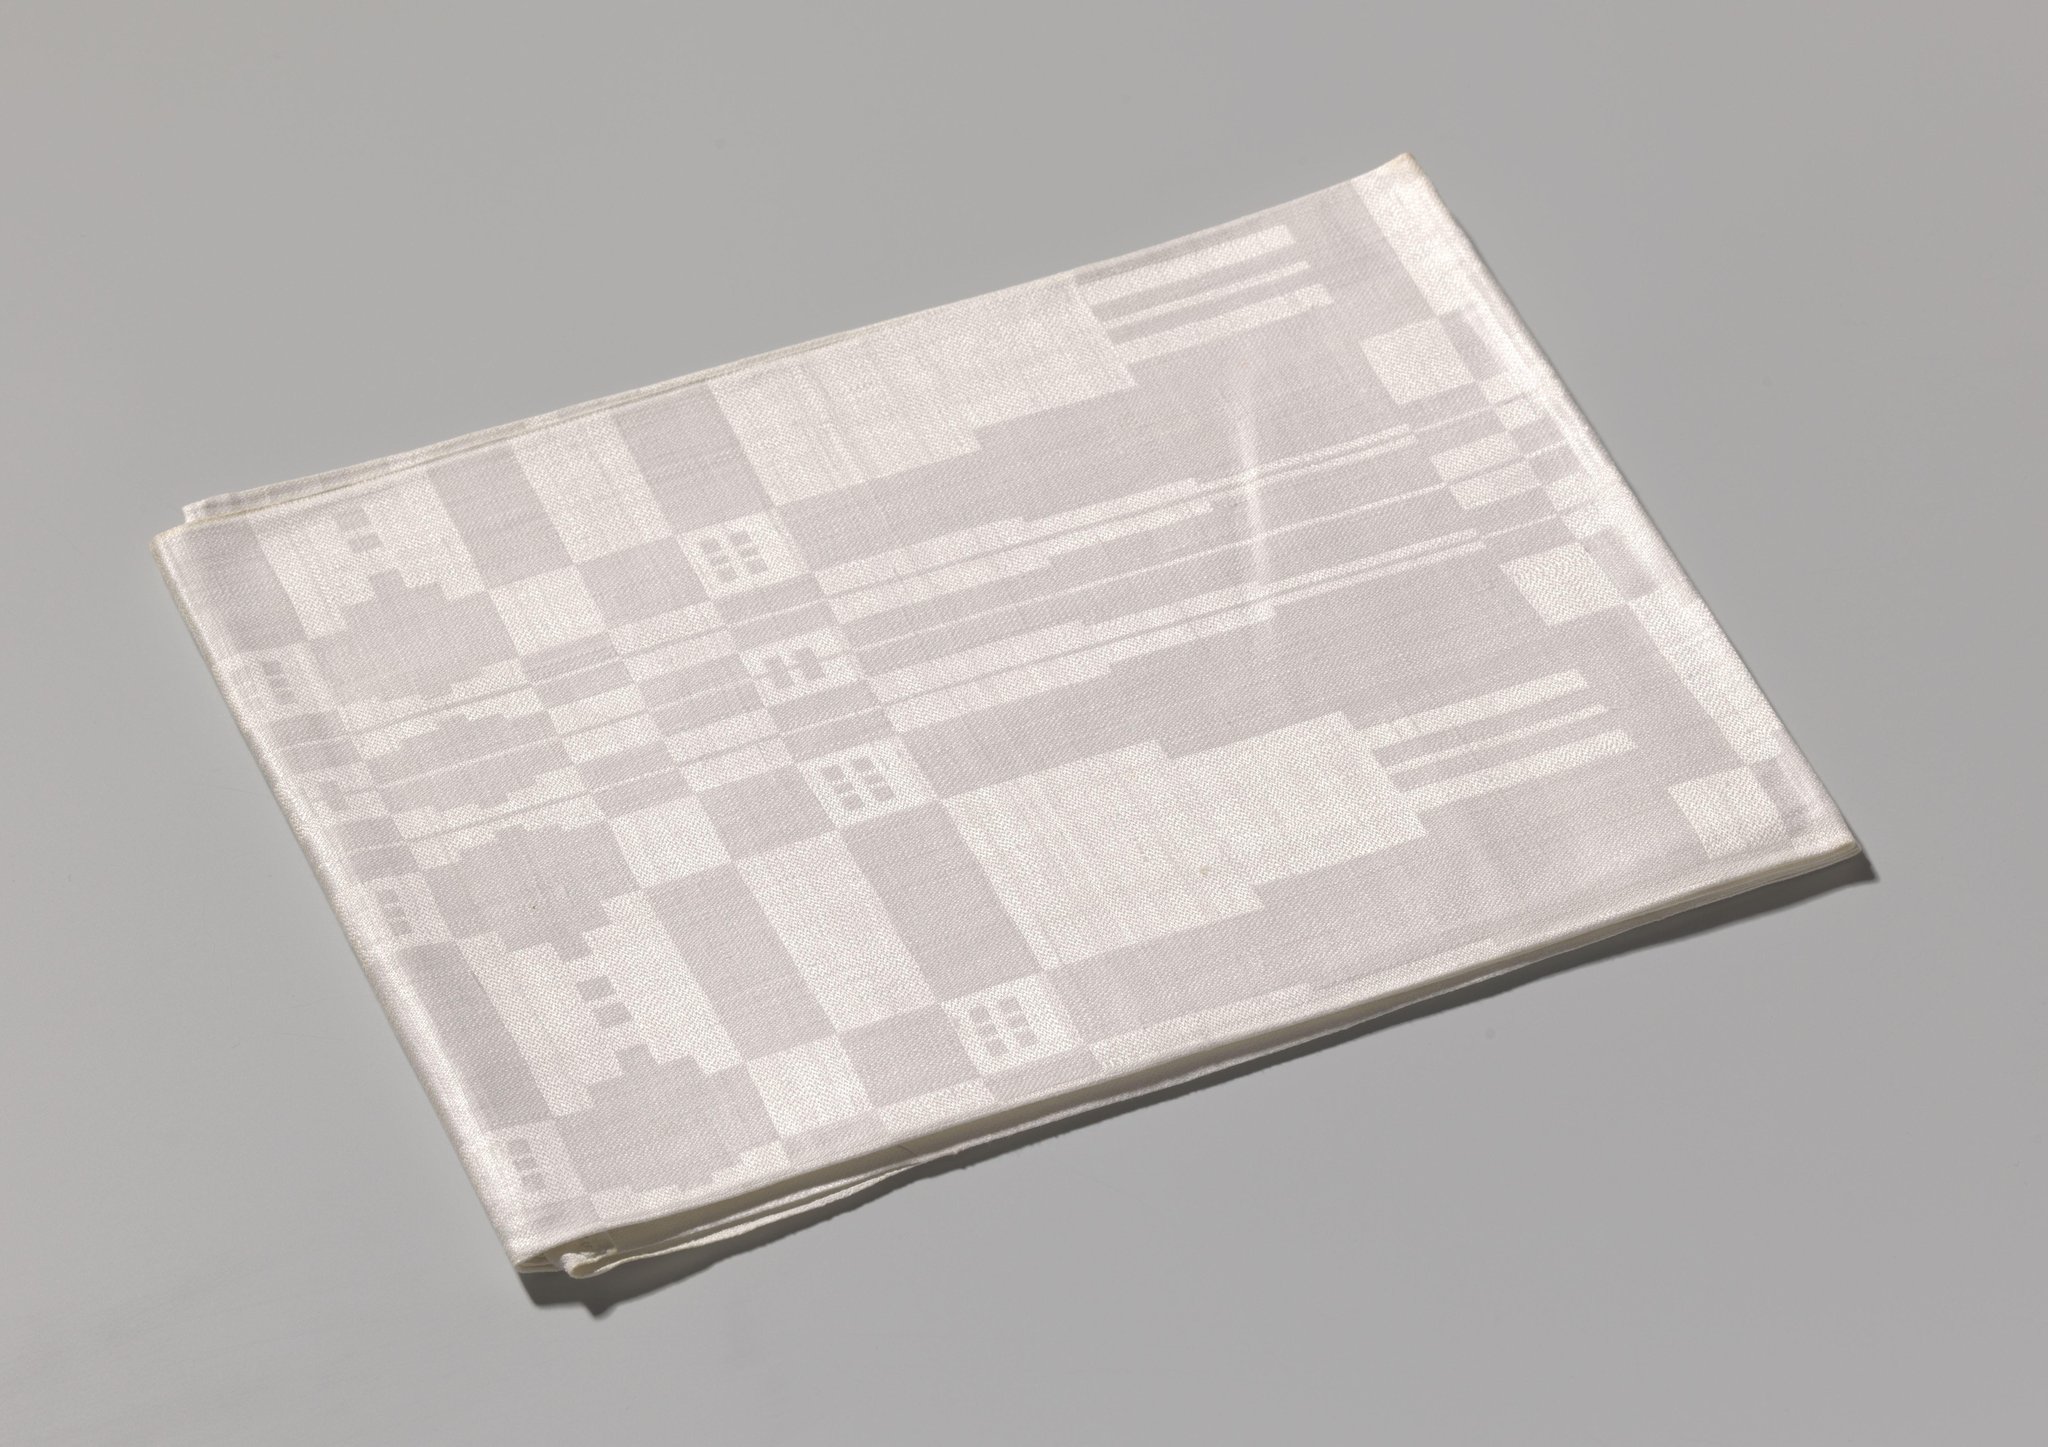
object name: napkin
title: Servet van linnen met pellenpatroon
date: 1742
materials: linen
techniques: peeled fabric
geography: northern netherlands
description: Wit linnendamasten servet met pellenpatroon, genaamd "Torenwerk". Merk kroon WG 44 1742.